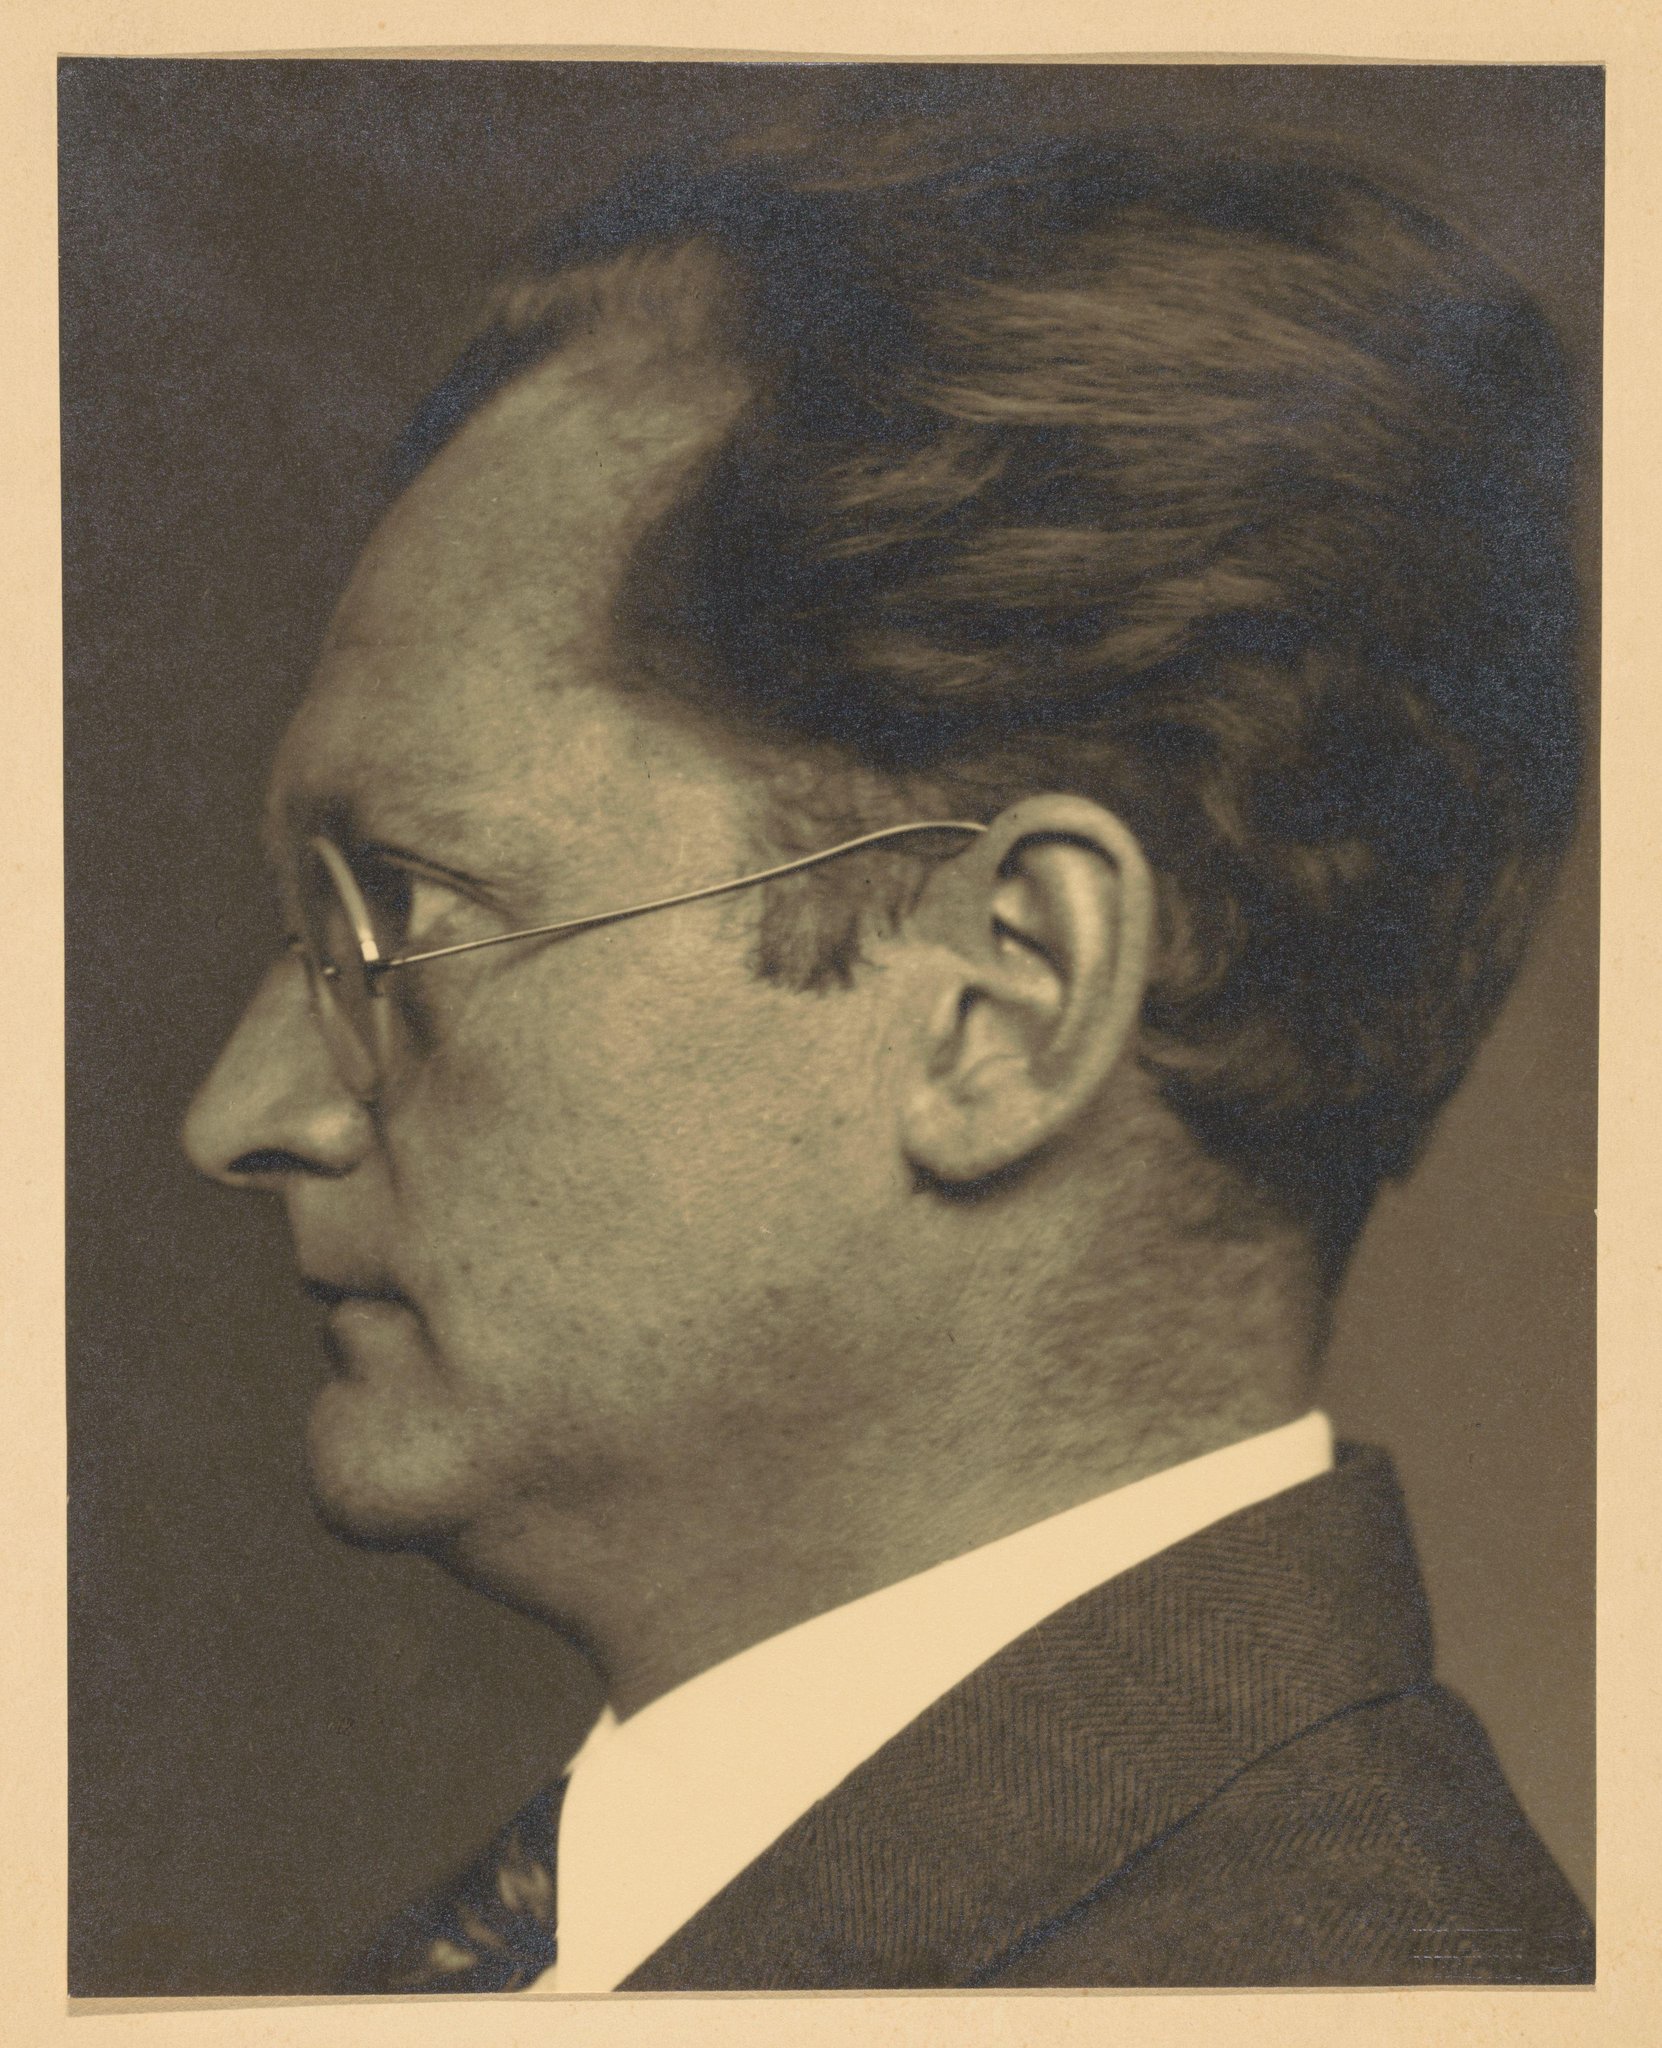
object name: photograph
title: Portret van Karl With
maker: hugo erfurth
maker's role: fotograaf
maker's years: 1874-1948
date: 1930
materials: paper, cardboard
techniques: gelatin silver print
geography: dresden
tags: karl with, adult man, historical persons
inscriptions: check stamp: ‘Erfurth/ Dresden/ Zinzendorf-/ Strasse 11.’, check stamp: ‘Hugo Erfurth/ Dresden 1930/ GDL [?]’